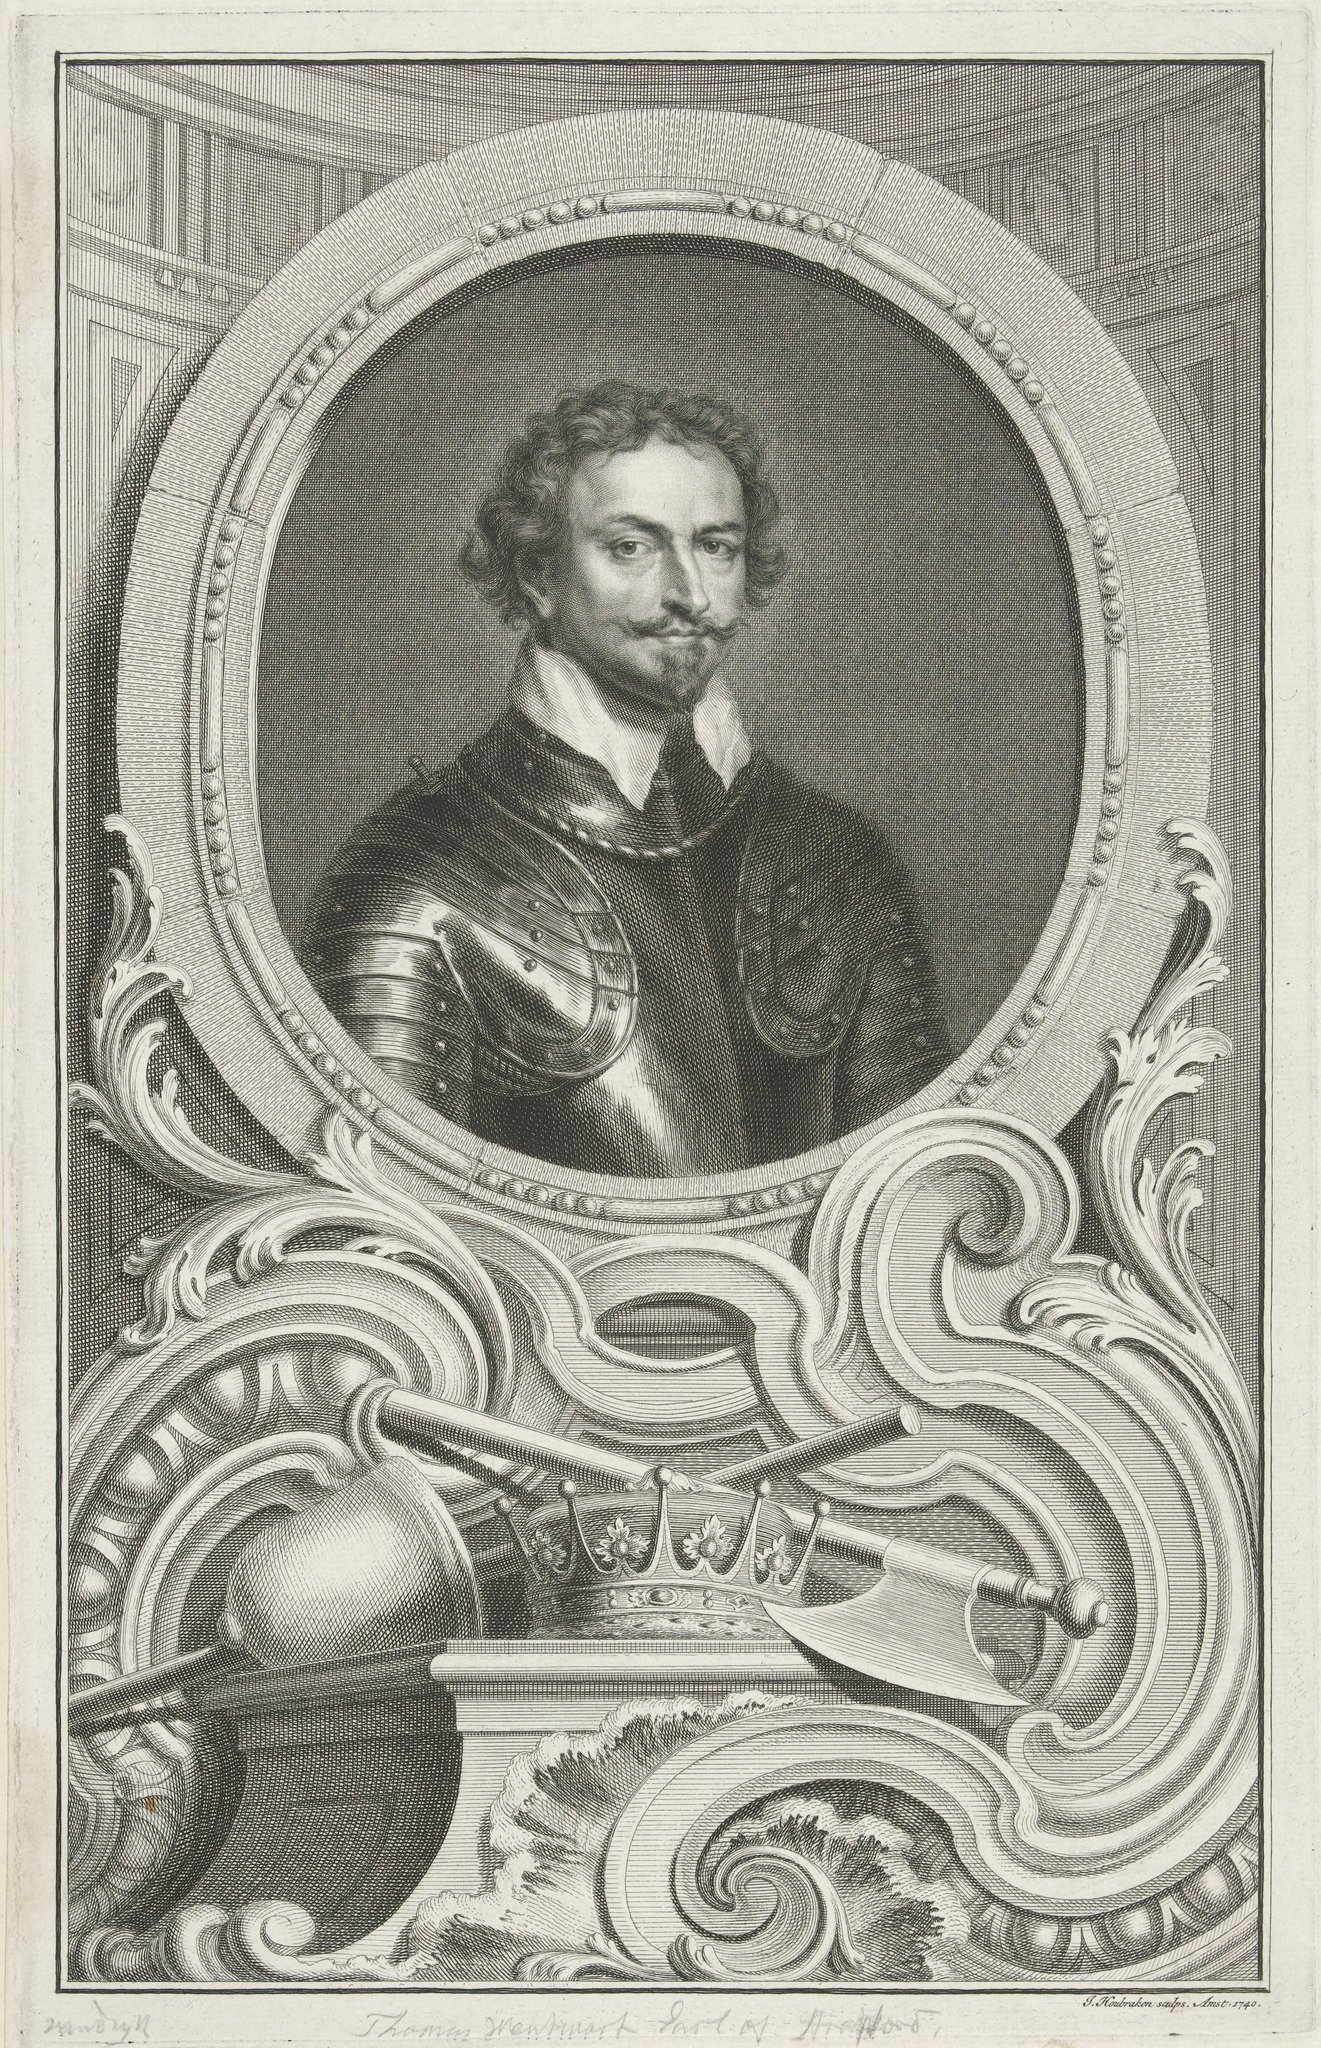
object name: print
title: Portret van Thomas Wentworth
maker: jacob houbraken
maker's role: draughtsman, print maker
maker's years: 1698-1780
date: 1740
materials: paper, pencil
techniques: engraving, etching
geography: amsterdam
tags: london, politician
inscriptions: name: ‘Vandijk’, name: ‘Thomas Wentwort Earl of Strafford’, collector's mark: Lugt 240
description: Prent ook gebruikt in: Thomas Birch. The heads of illustrious persons of Great Britain : engraved by Houbraken, and Vertue, with their lives and characters. London: John en Paul Knapton, 1743-1751.